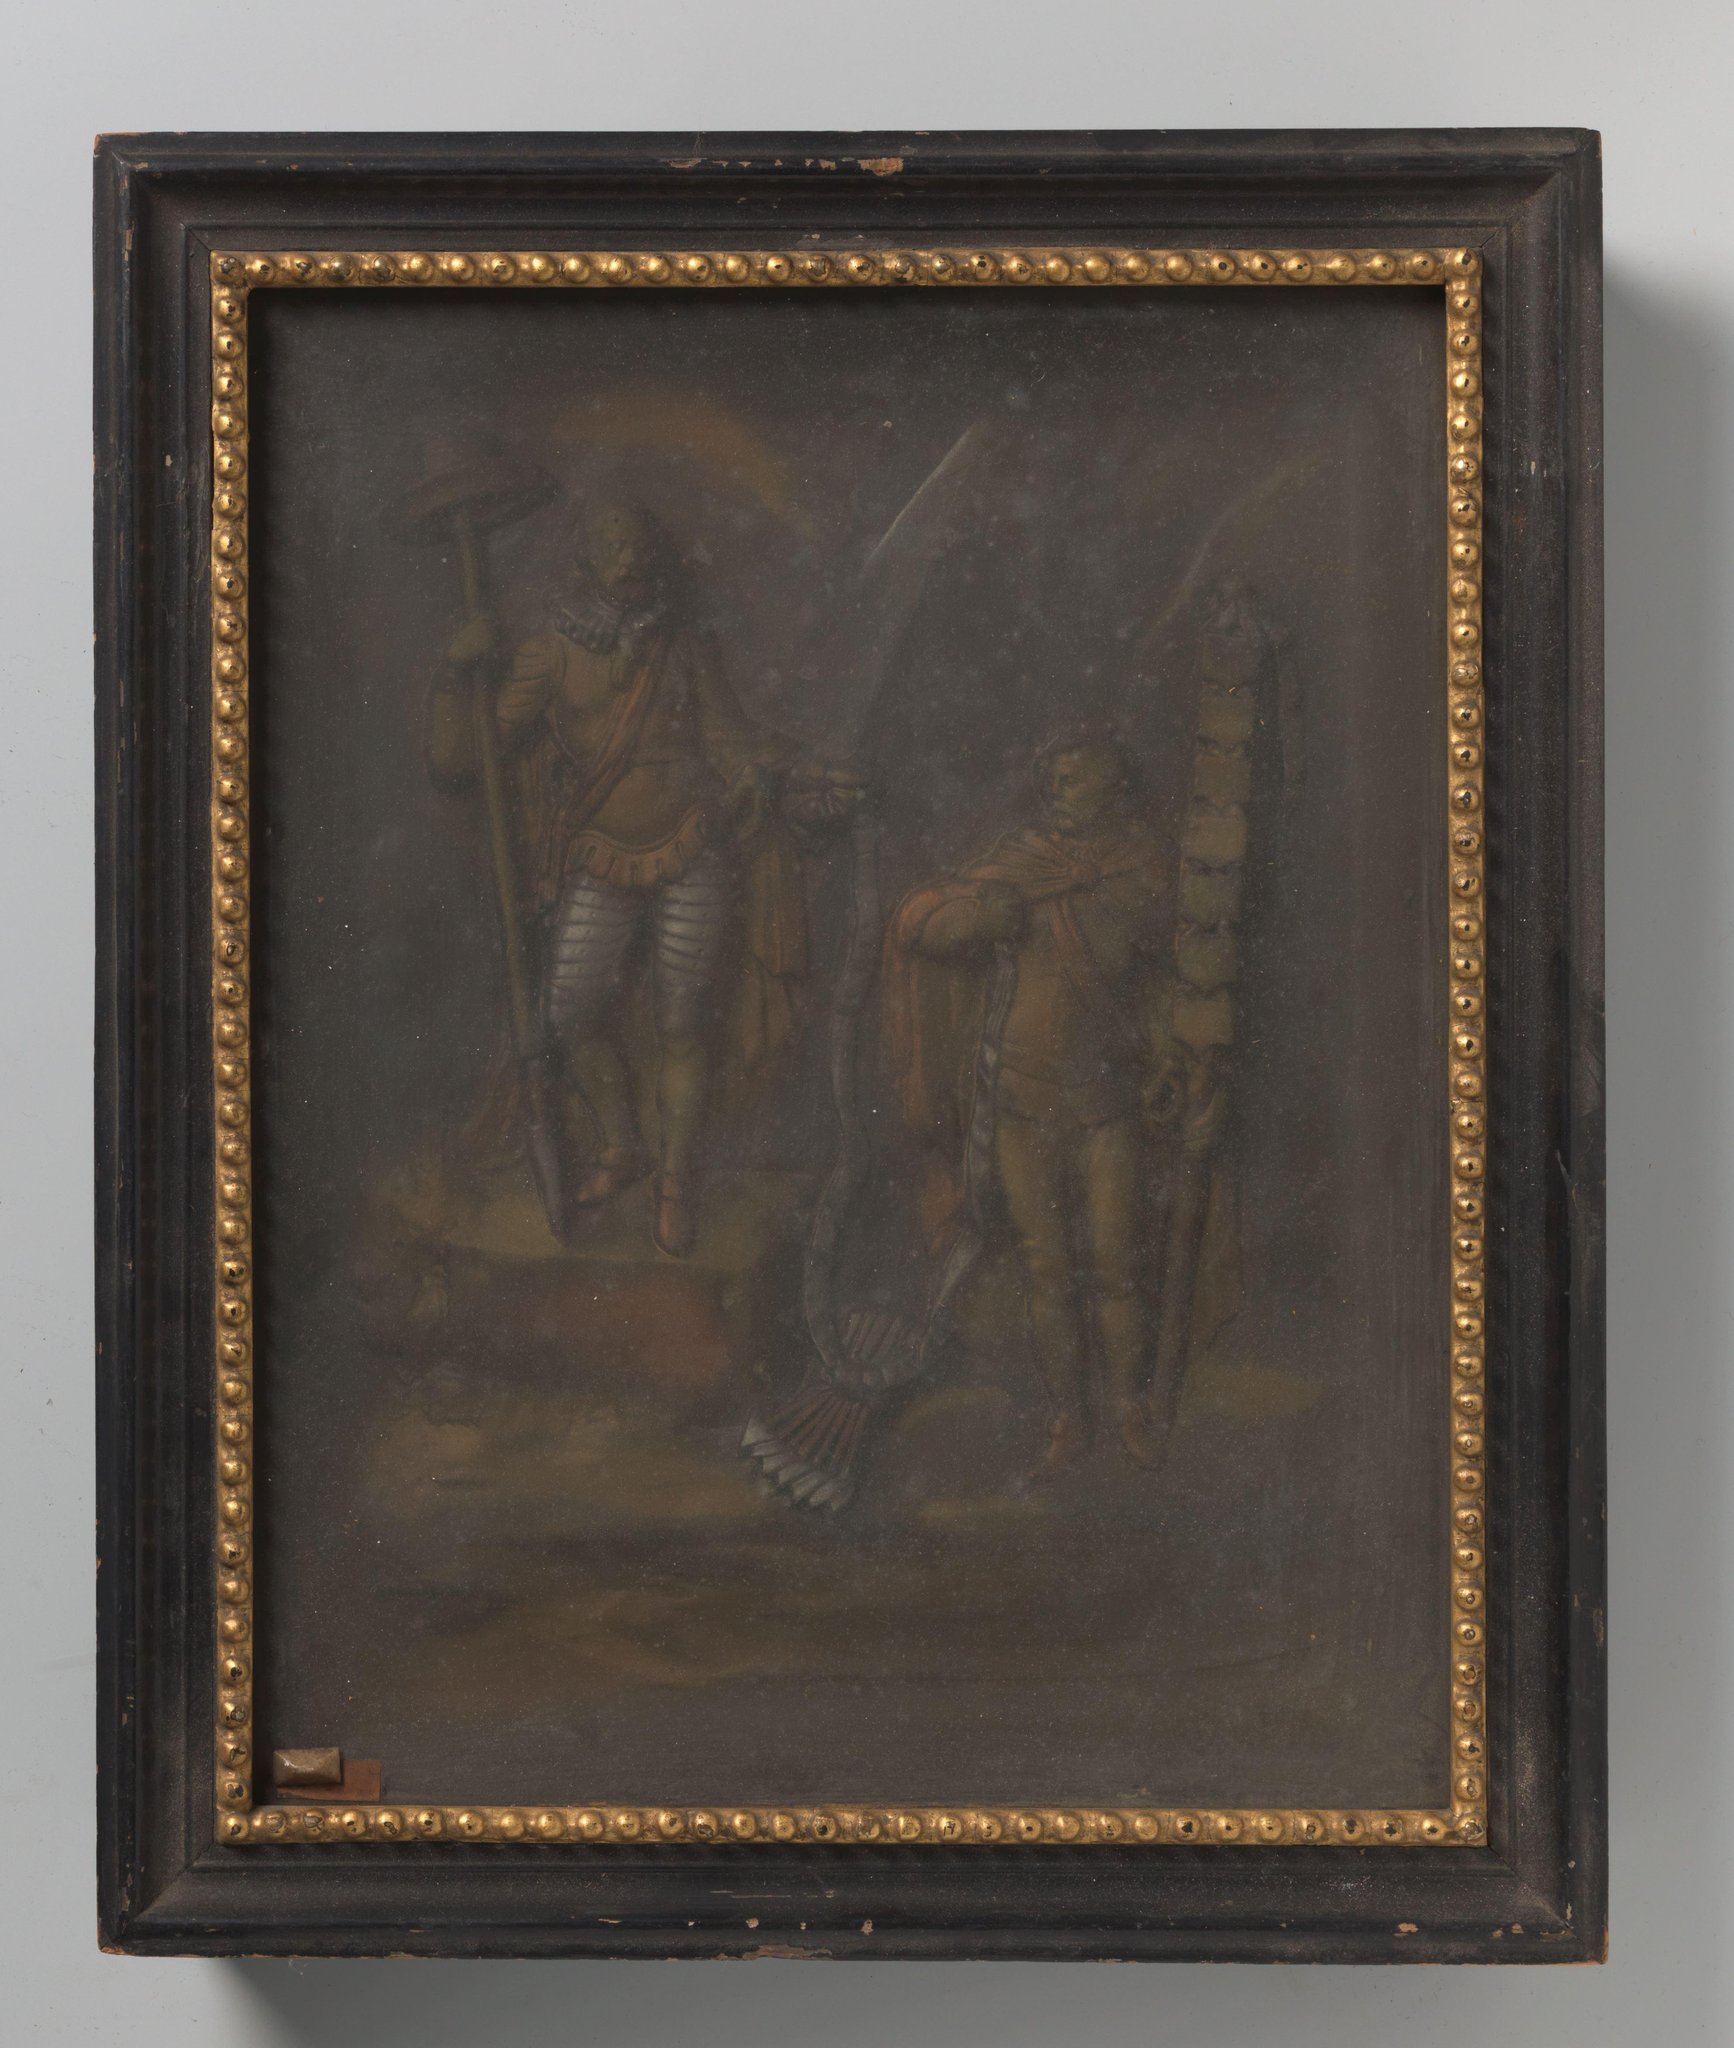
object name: relief sculpture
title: Reliëf van gekleurd gips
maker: Anonymous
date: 1700-1799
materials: gypsum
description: Een van de zes gekleurde gipsreliëfs achtger glas in lijst, voorstellende de vrijheid enz. met Prins Willem I tot Prins Willem V.